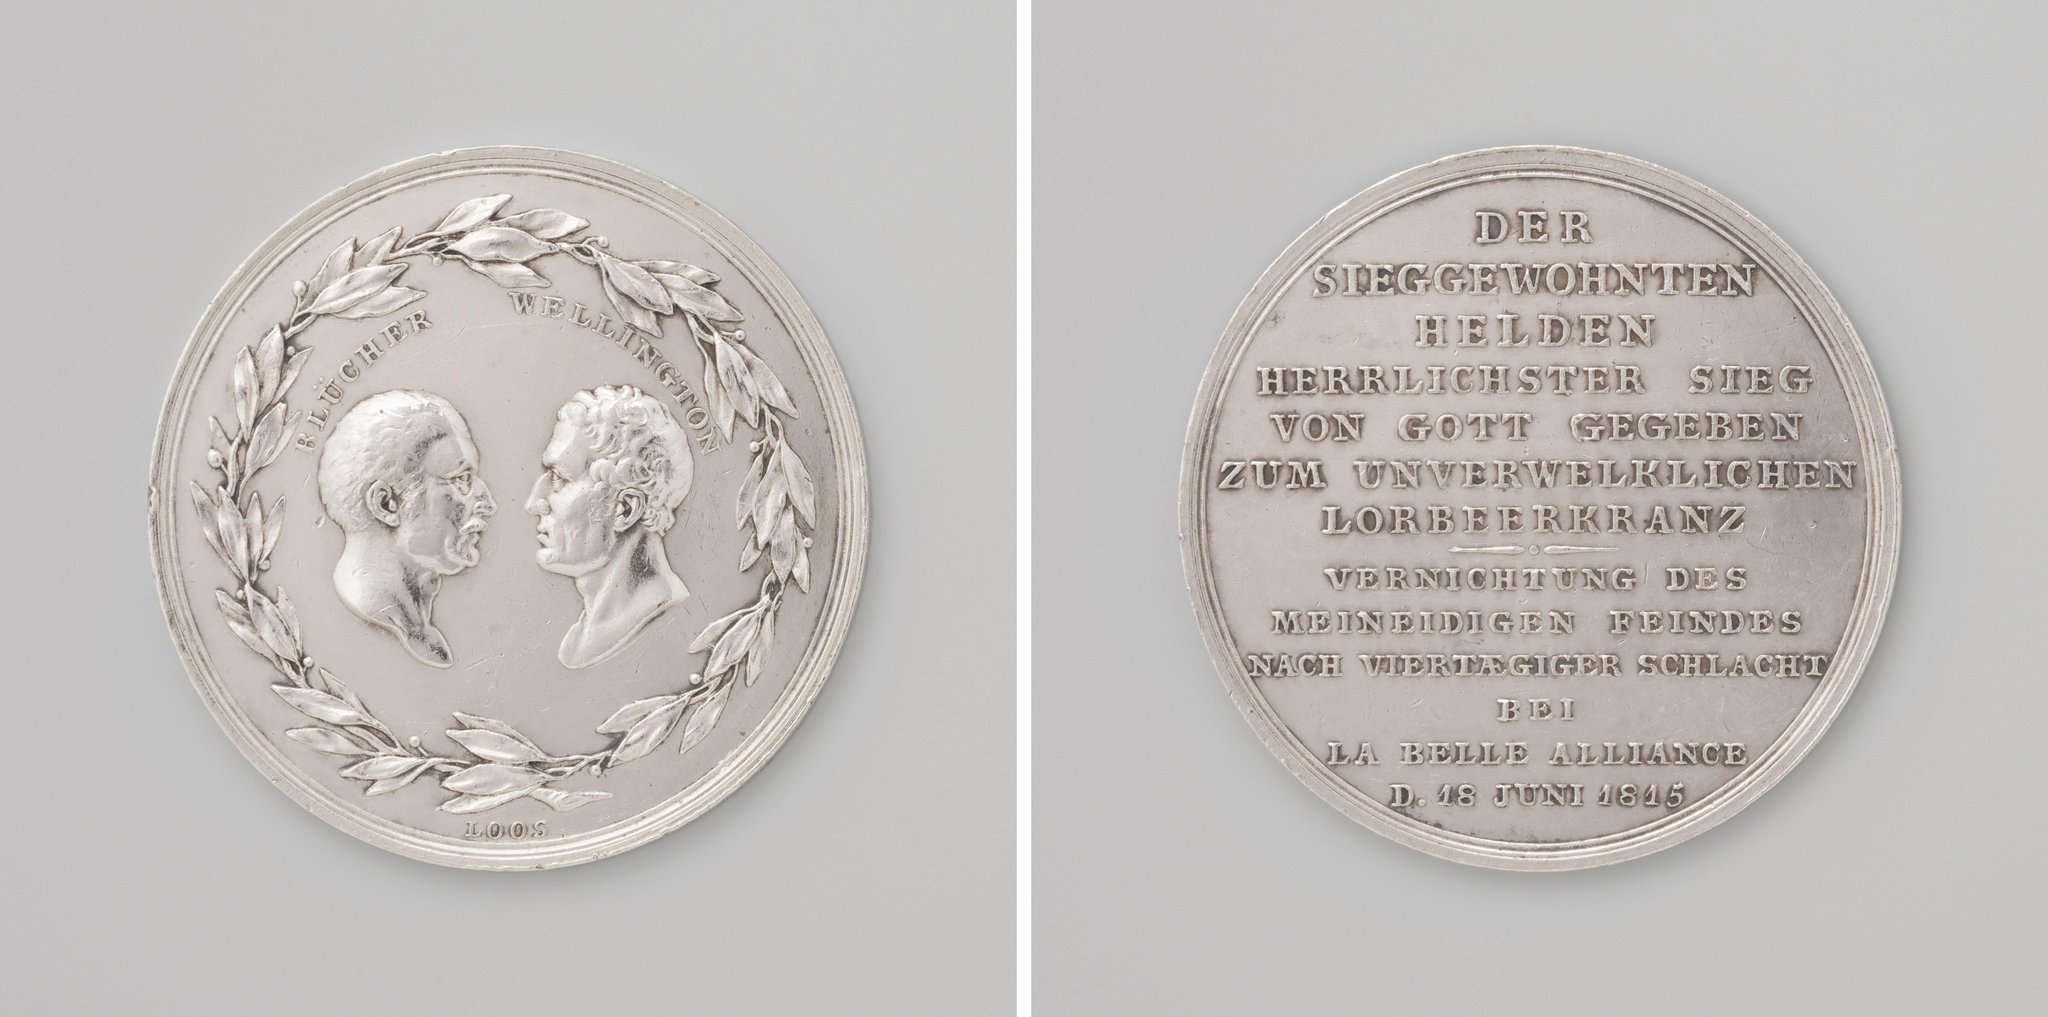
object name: history medal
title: Slag bij Waterloo, ter ere van de hertog van Wellington en Blucher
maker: daniel friedrich loos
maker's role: medailleur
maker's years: 1735-1819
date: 1815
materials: silver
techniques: striking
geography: berlin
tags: walmer castle, arthur wellesley of wellington, waterloo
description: Zilveren penning. Voorzijde: naar elkaar gewende borststukken van twee mannen binnen omschrift en lauwerkrans. Keerzijde: opschrift